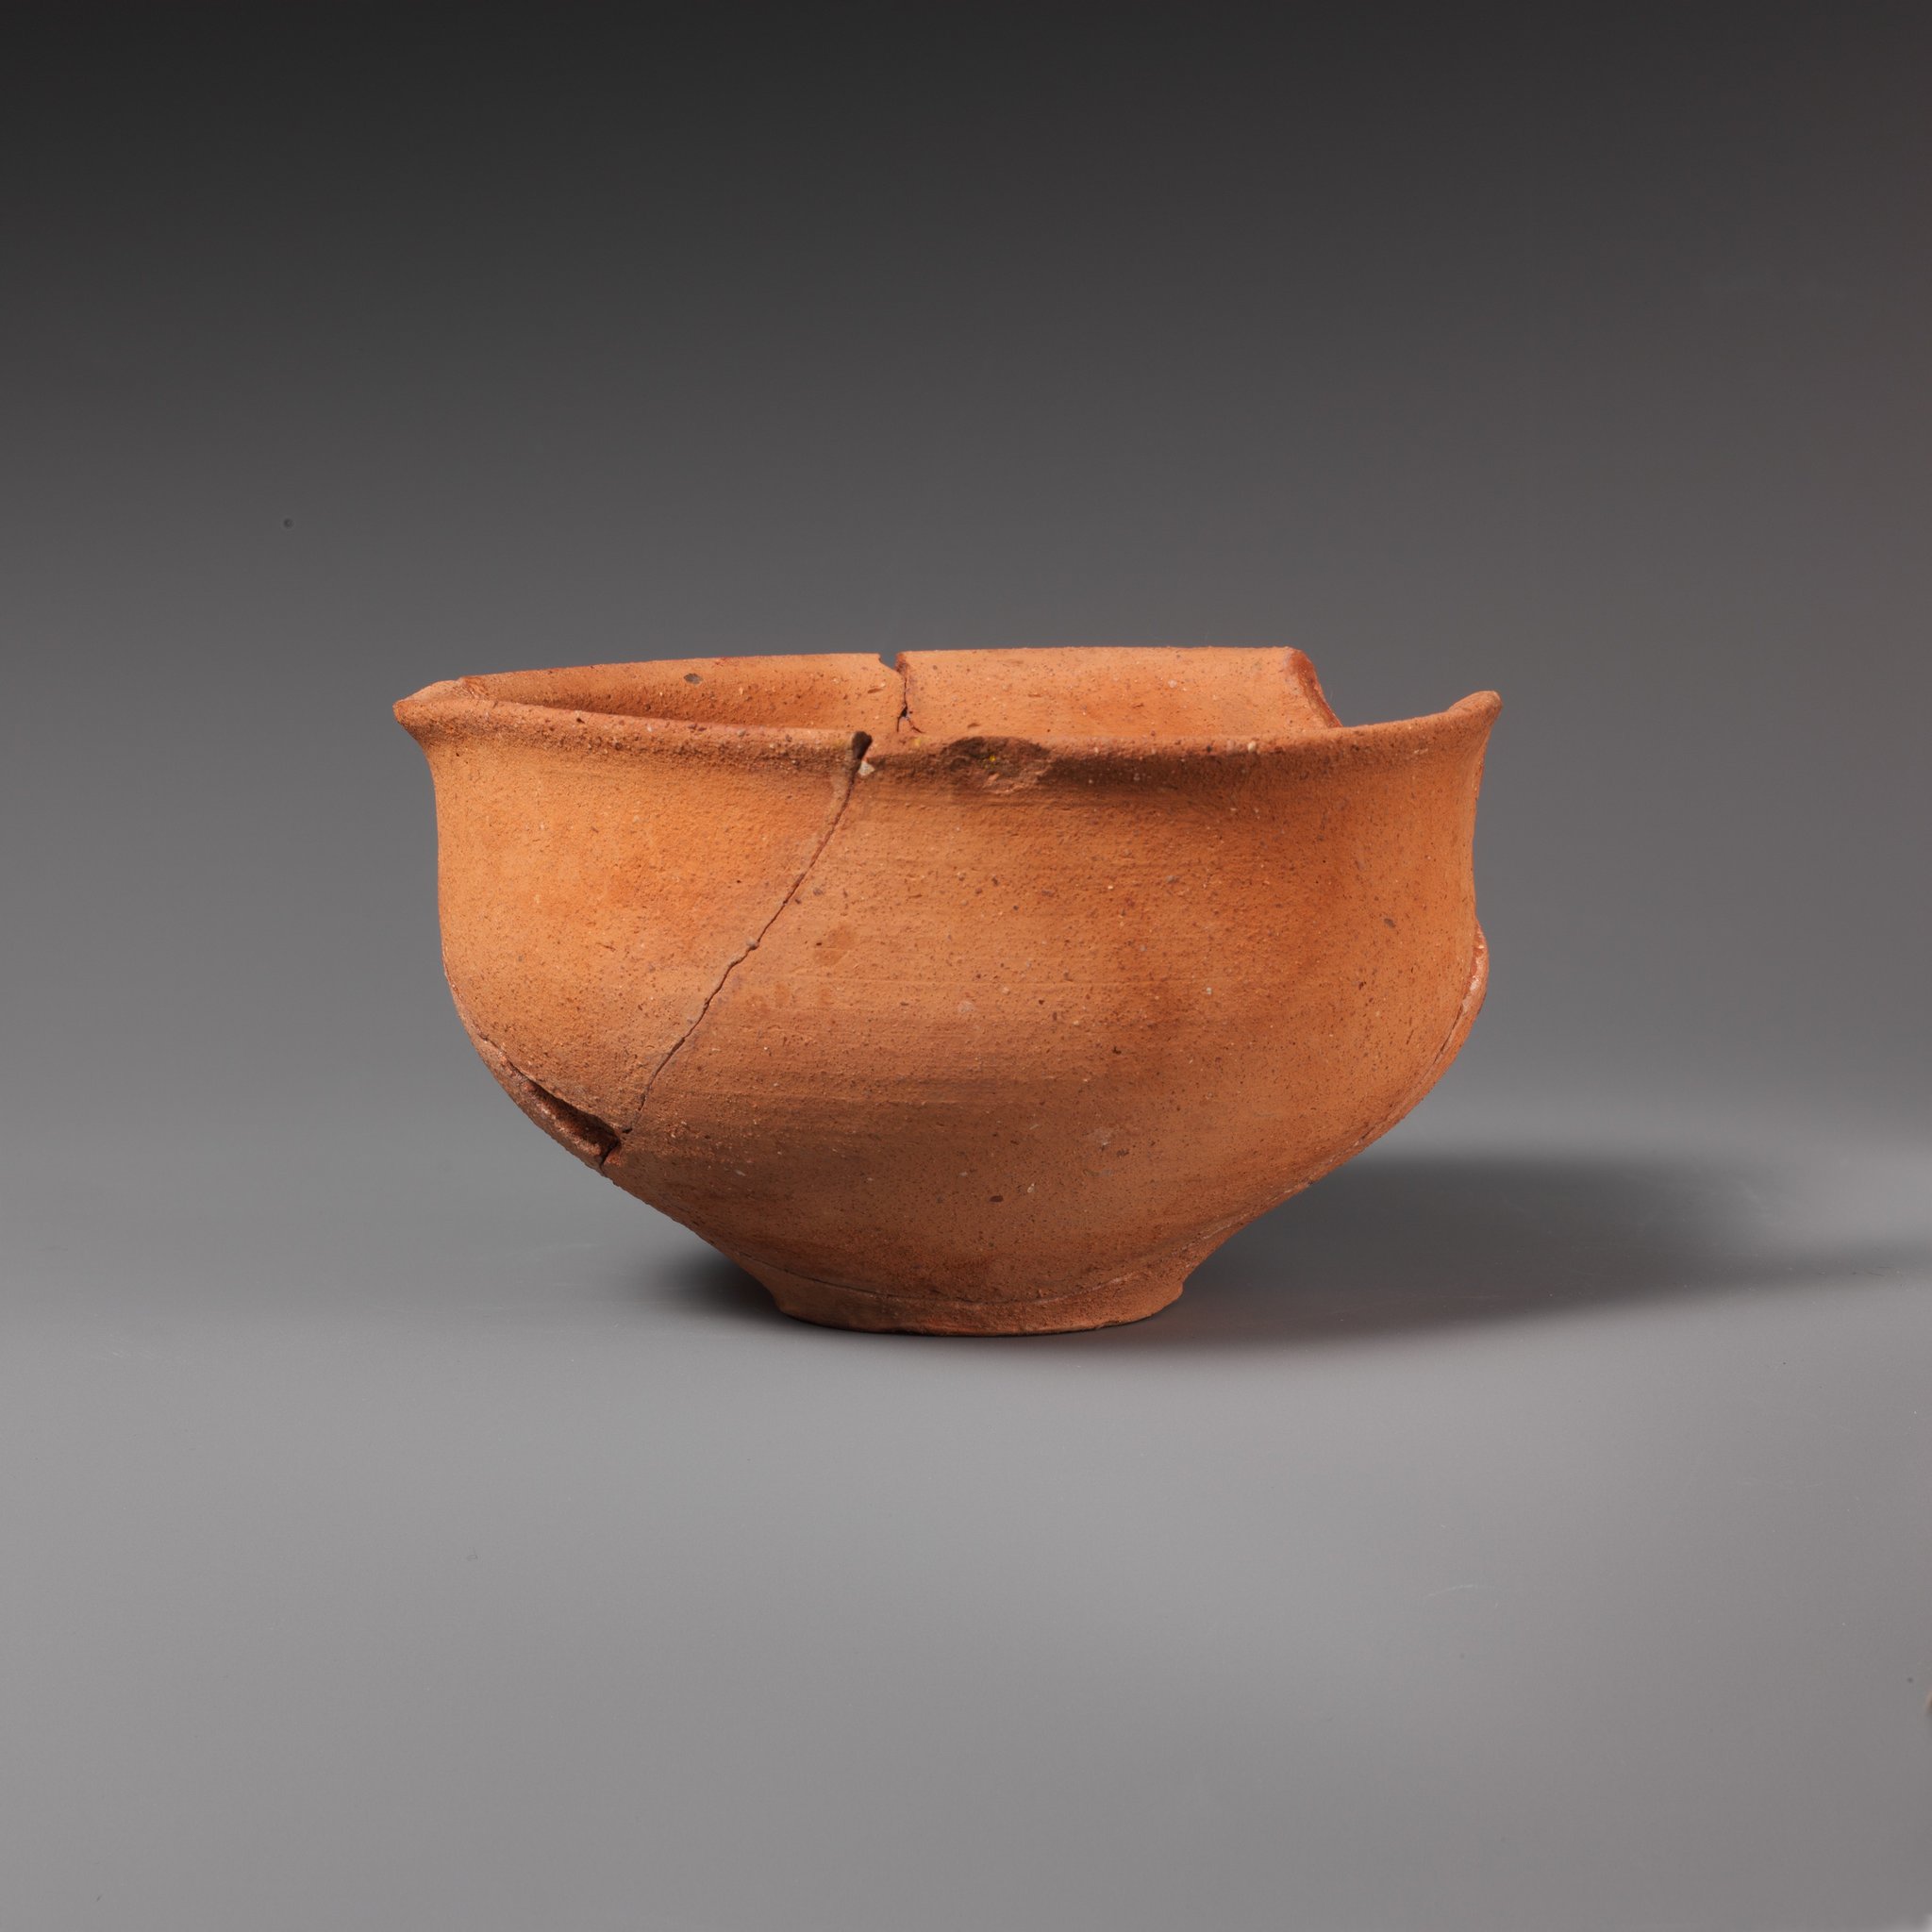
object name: bowl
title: Terracotta pulled-rim bowl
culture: mycenaean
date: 1400-1050 BCE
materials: terracotta